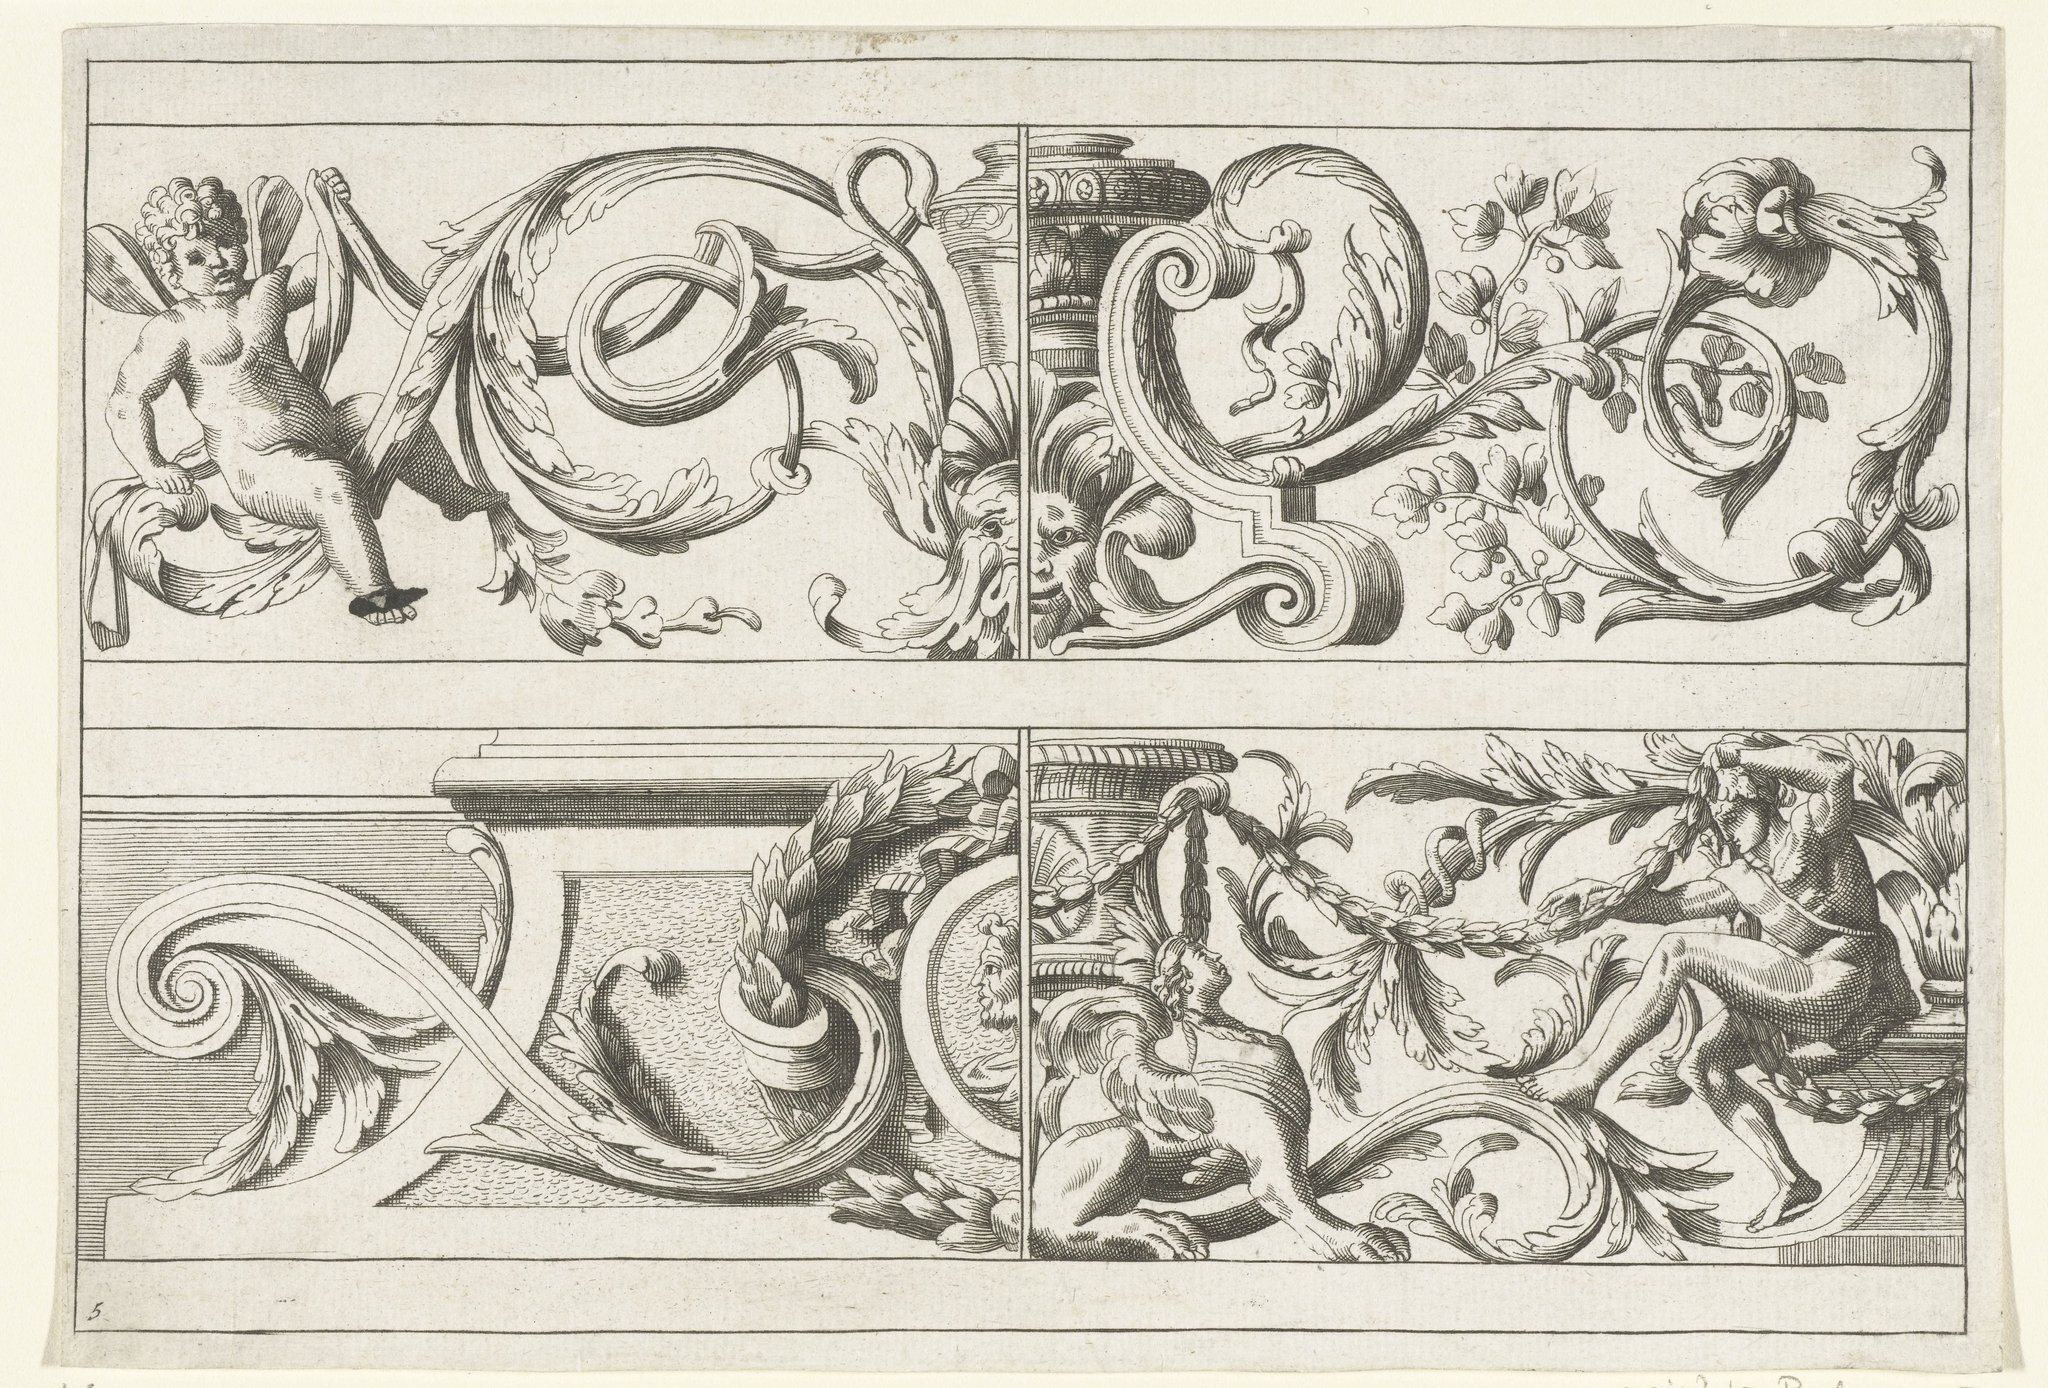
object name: print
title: Fries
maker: Anonymous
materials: paper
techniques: etching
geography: netherlands